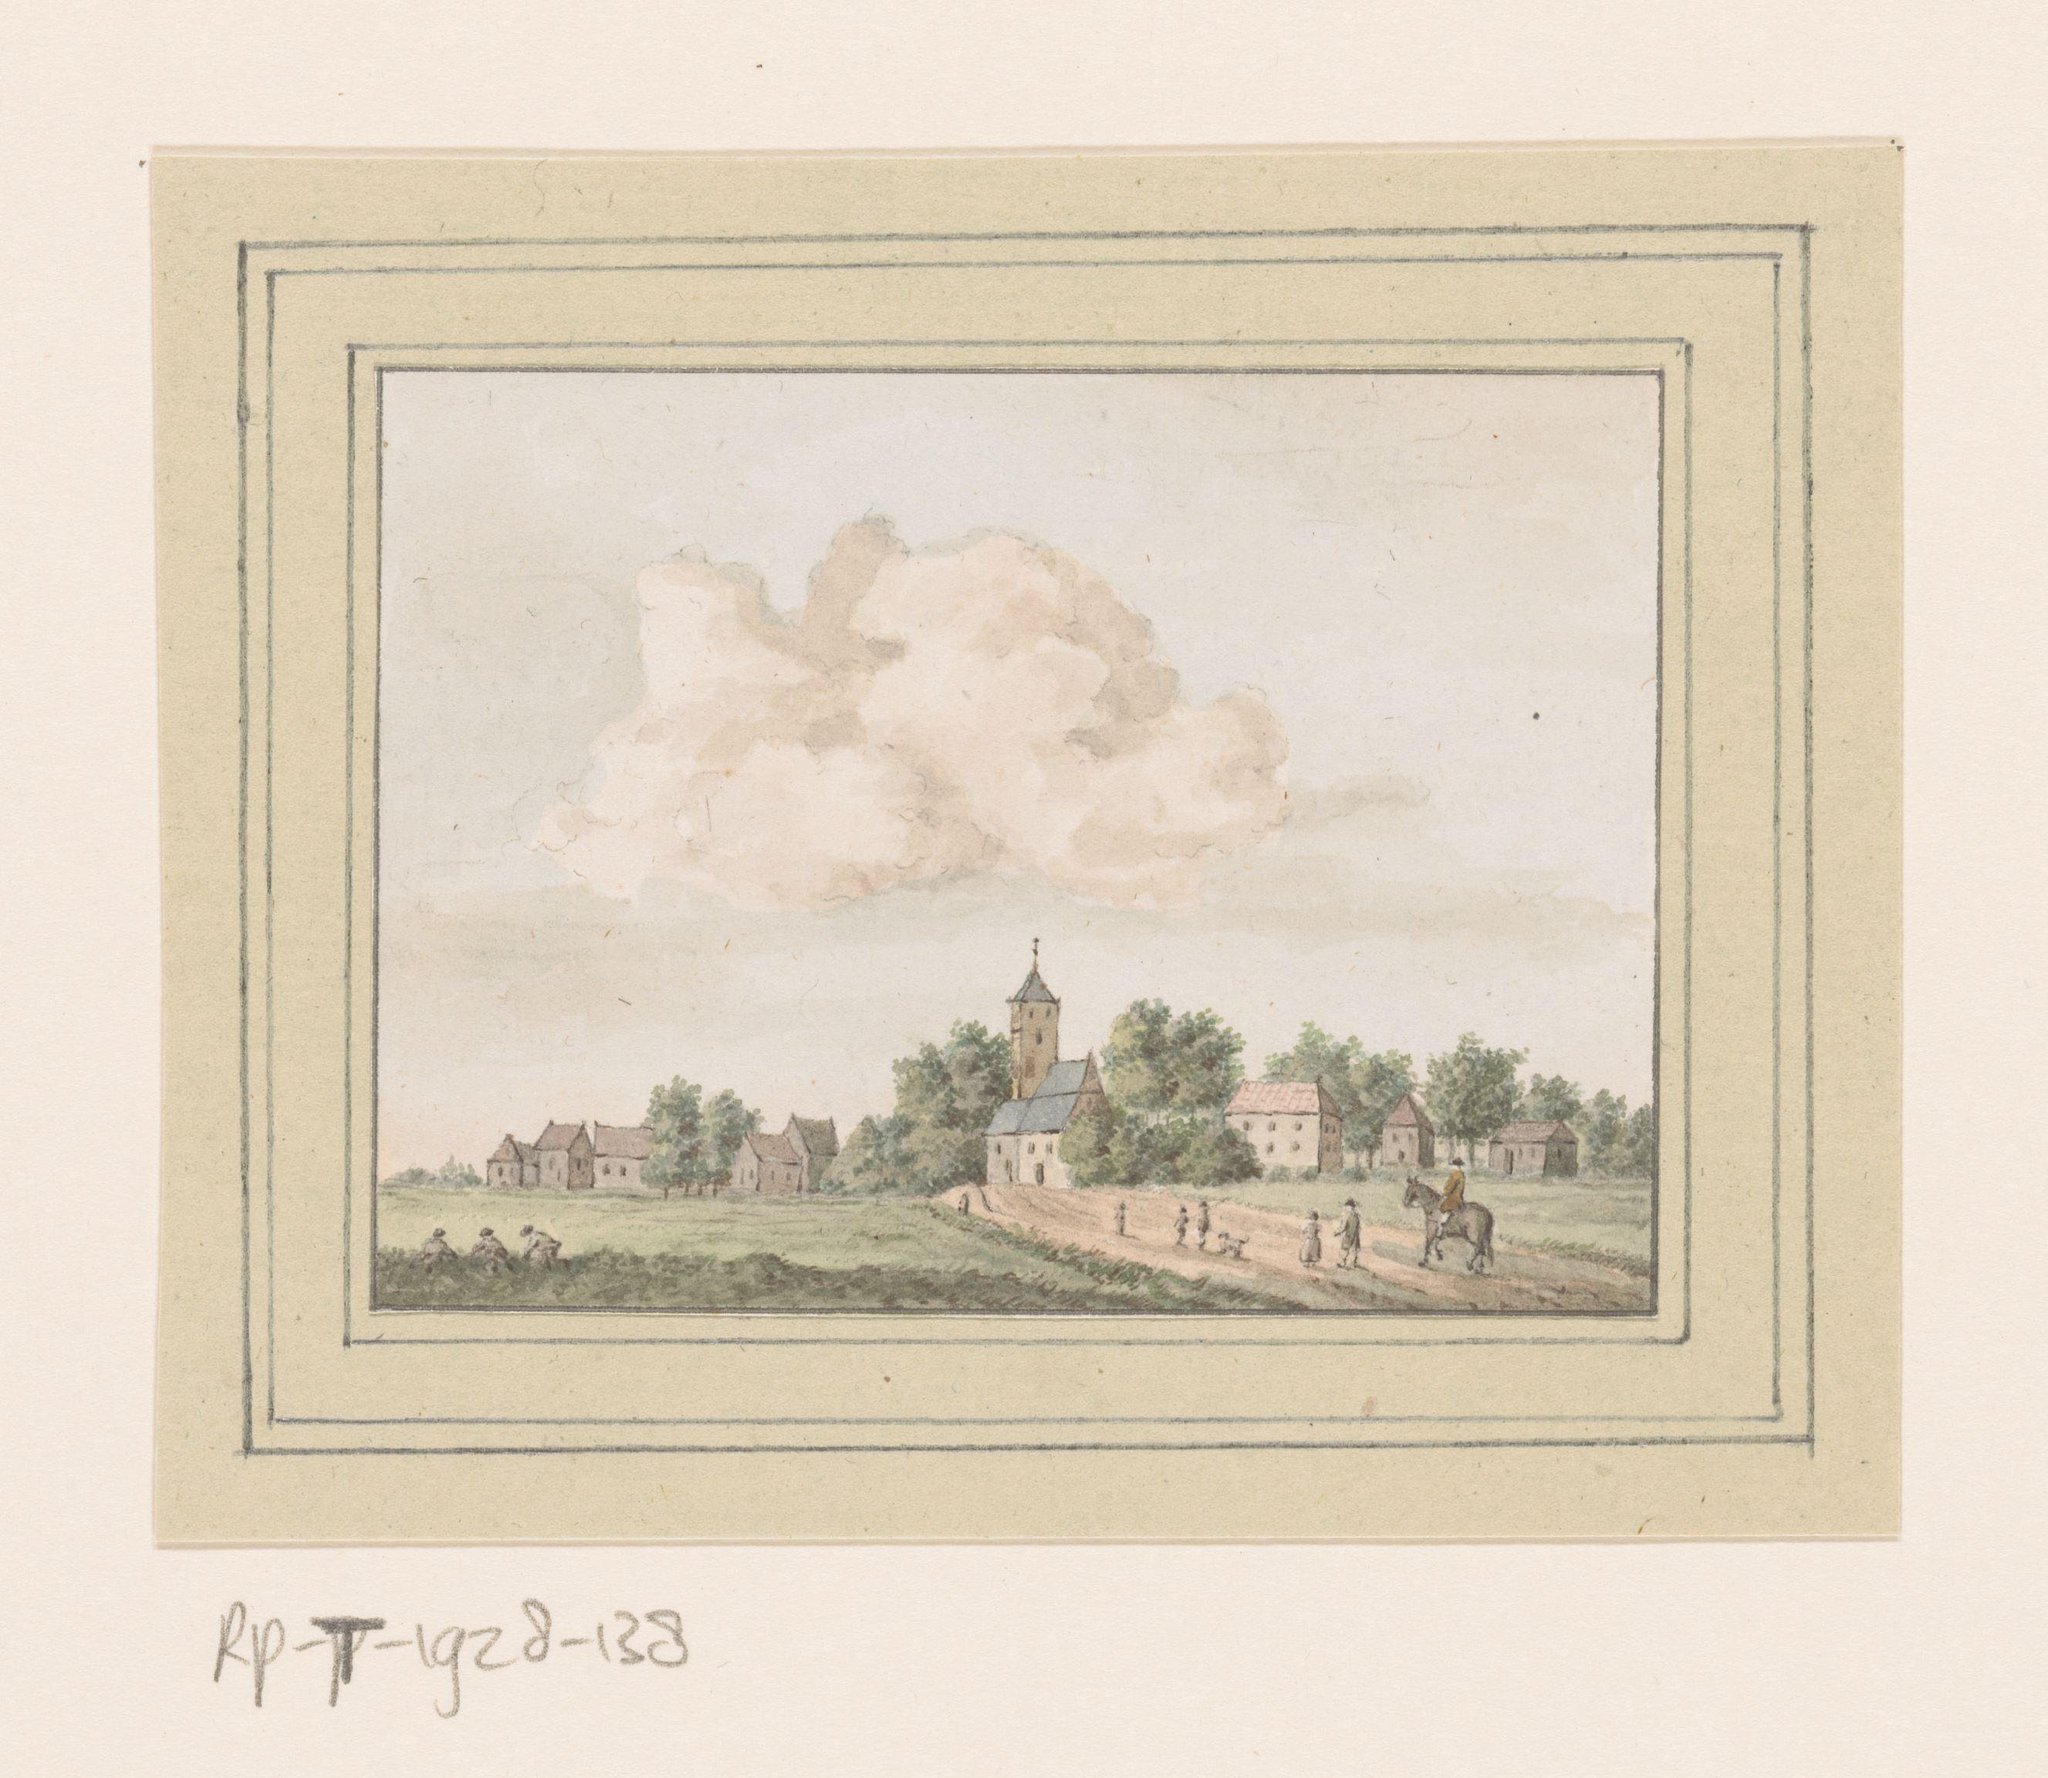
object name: drawing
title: Gezicht op Serooskerke in Zeeland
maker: Anonymous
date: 1754-1800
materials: ink, paper, pencil, watercolor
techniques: brush, pen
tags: prospect of village, silhouette of village (+ city(-scape) with figures, staffage)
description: Kopie naar de prent van Hendrik Spilman, zie RP-P-AO-15-126-18-3.